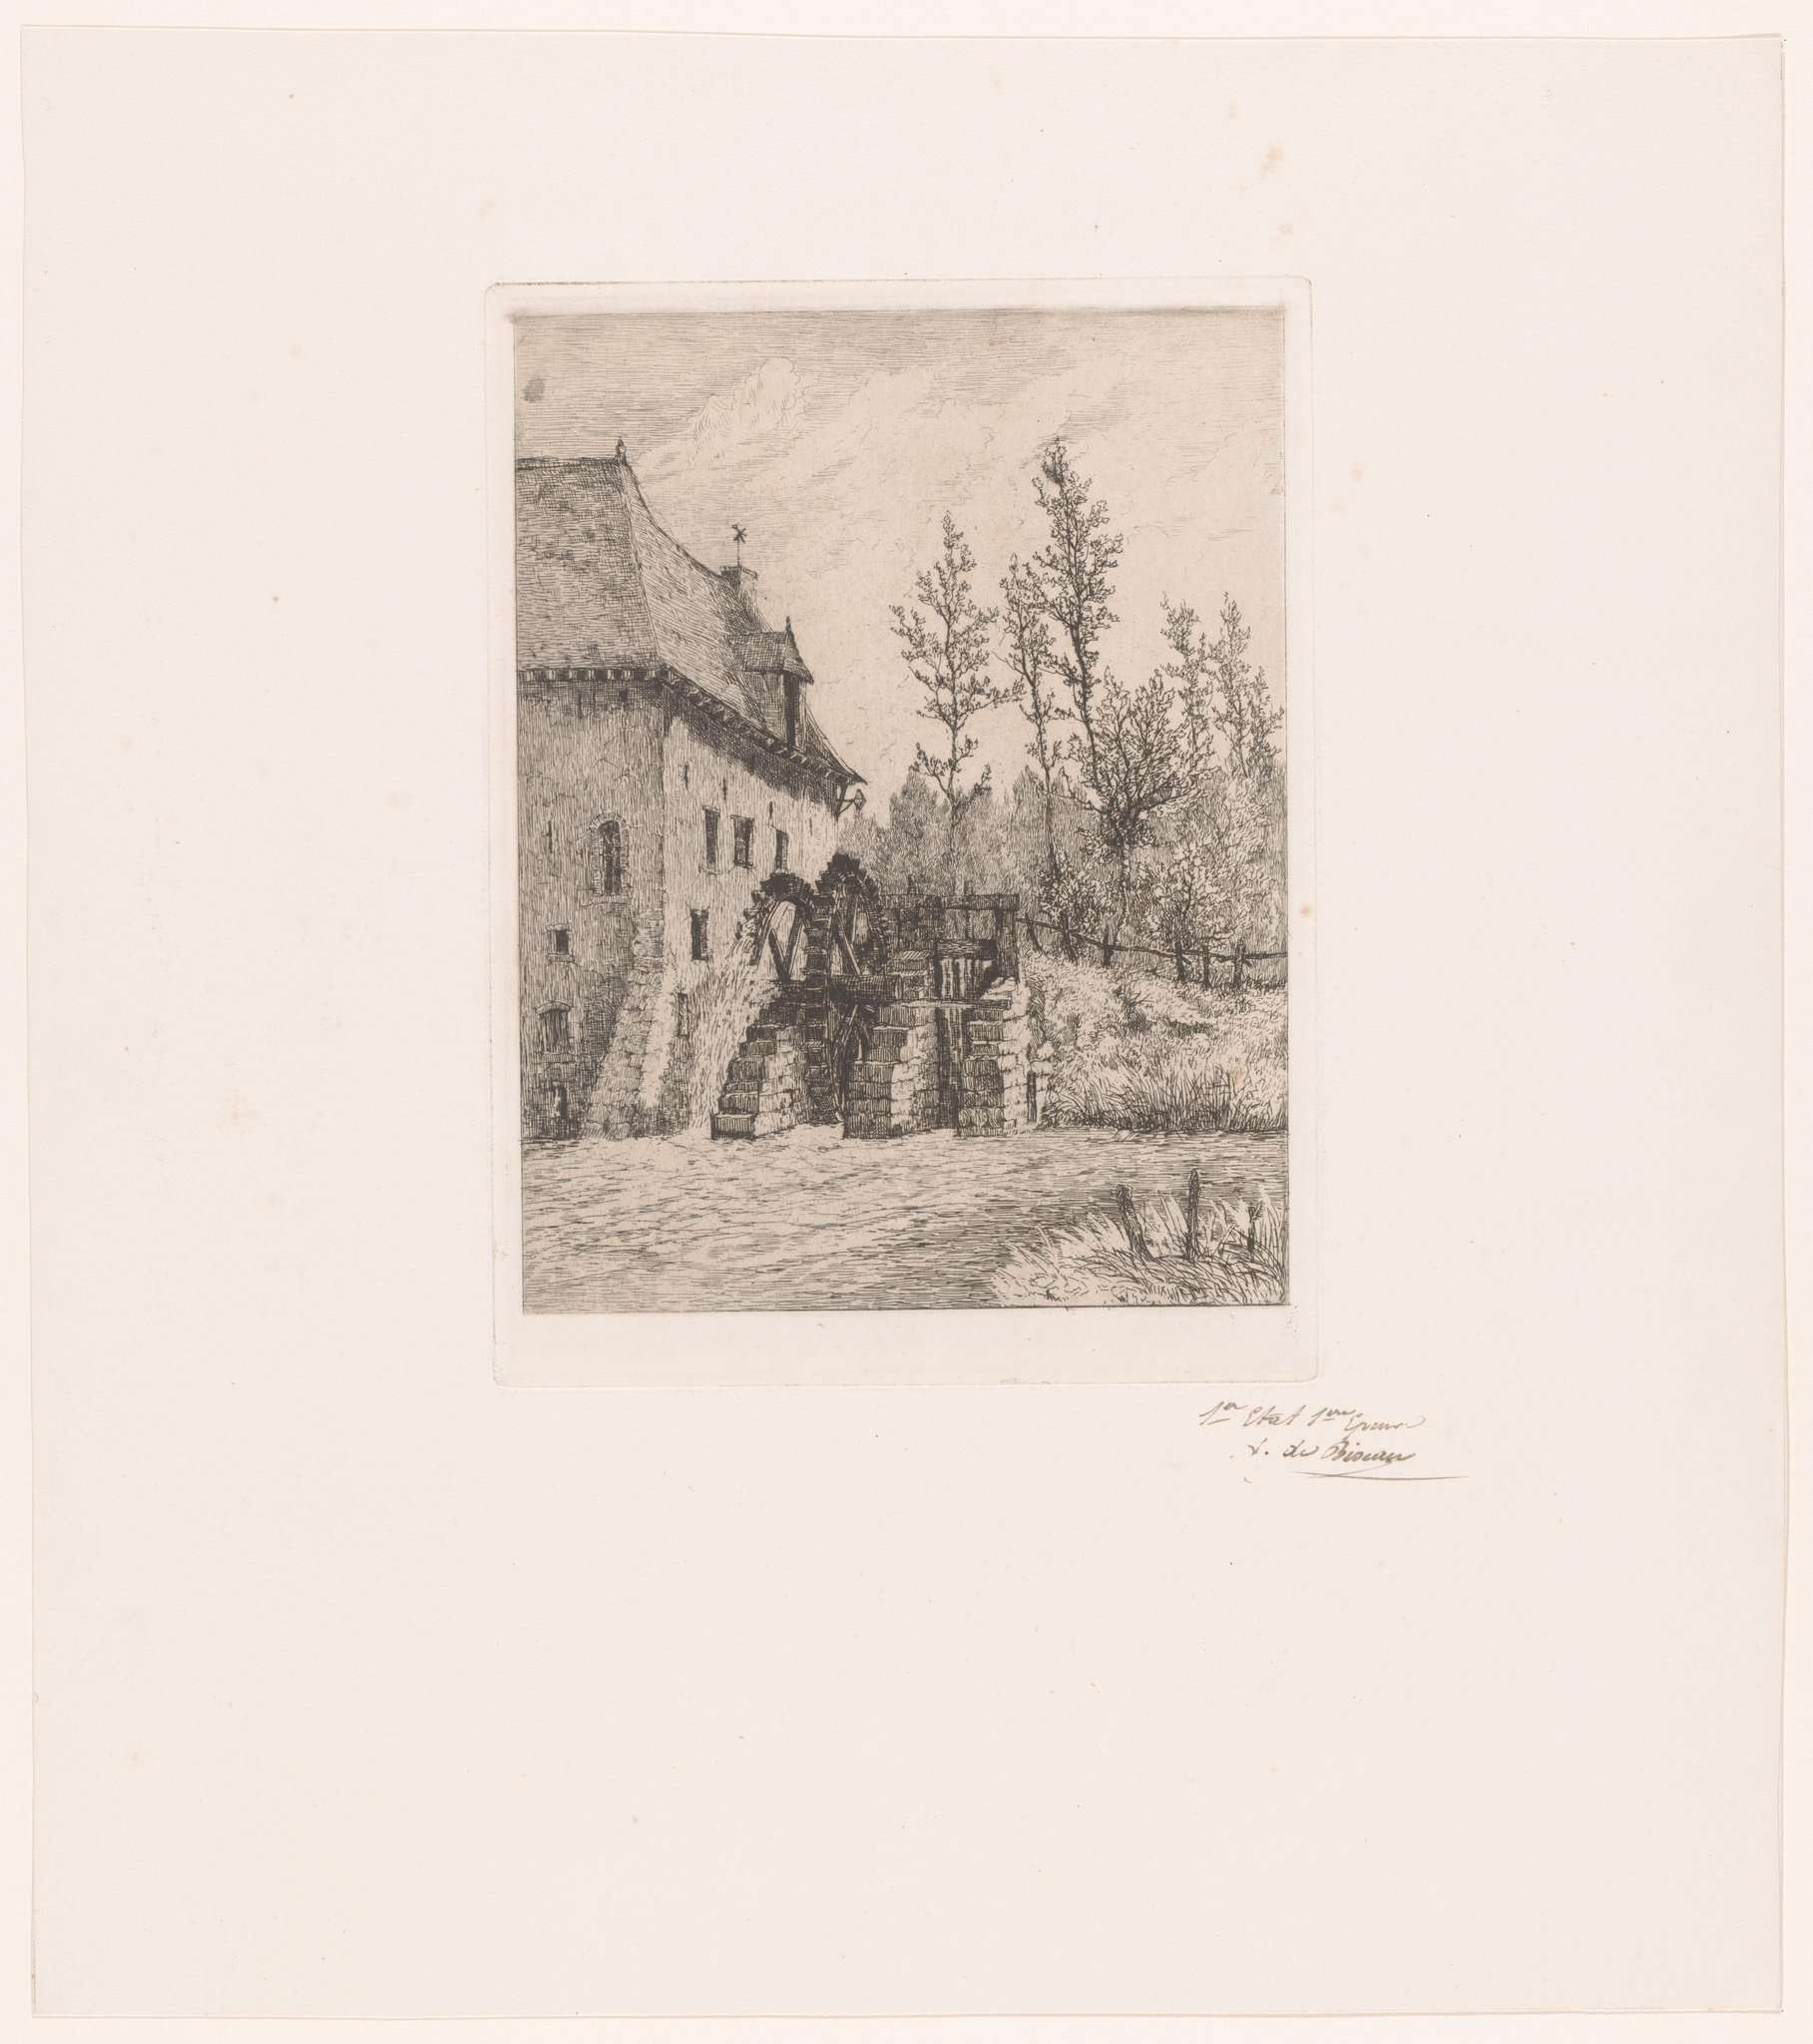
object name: print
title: Watermolen van Sint-Pieters-Leeuw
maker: aristide de biseau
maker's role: print maker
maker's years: 1844-1883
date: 1854-1883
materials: paper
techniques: etching, intaglio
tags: watermill in landscape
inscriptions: annotation: ‘1er Etat 1ere Epreuve’, collector's mark: Lugt 2228